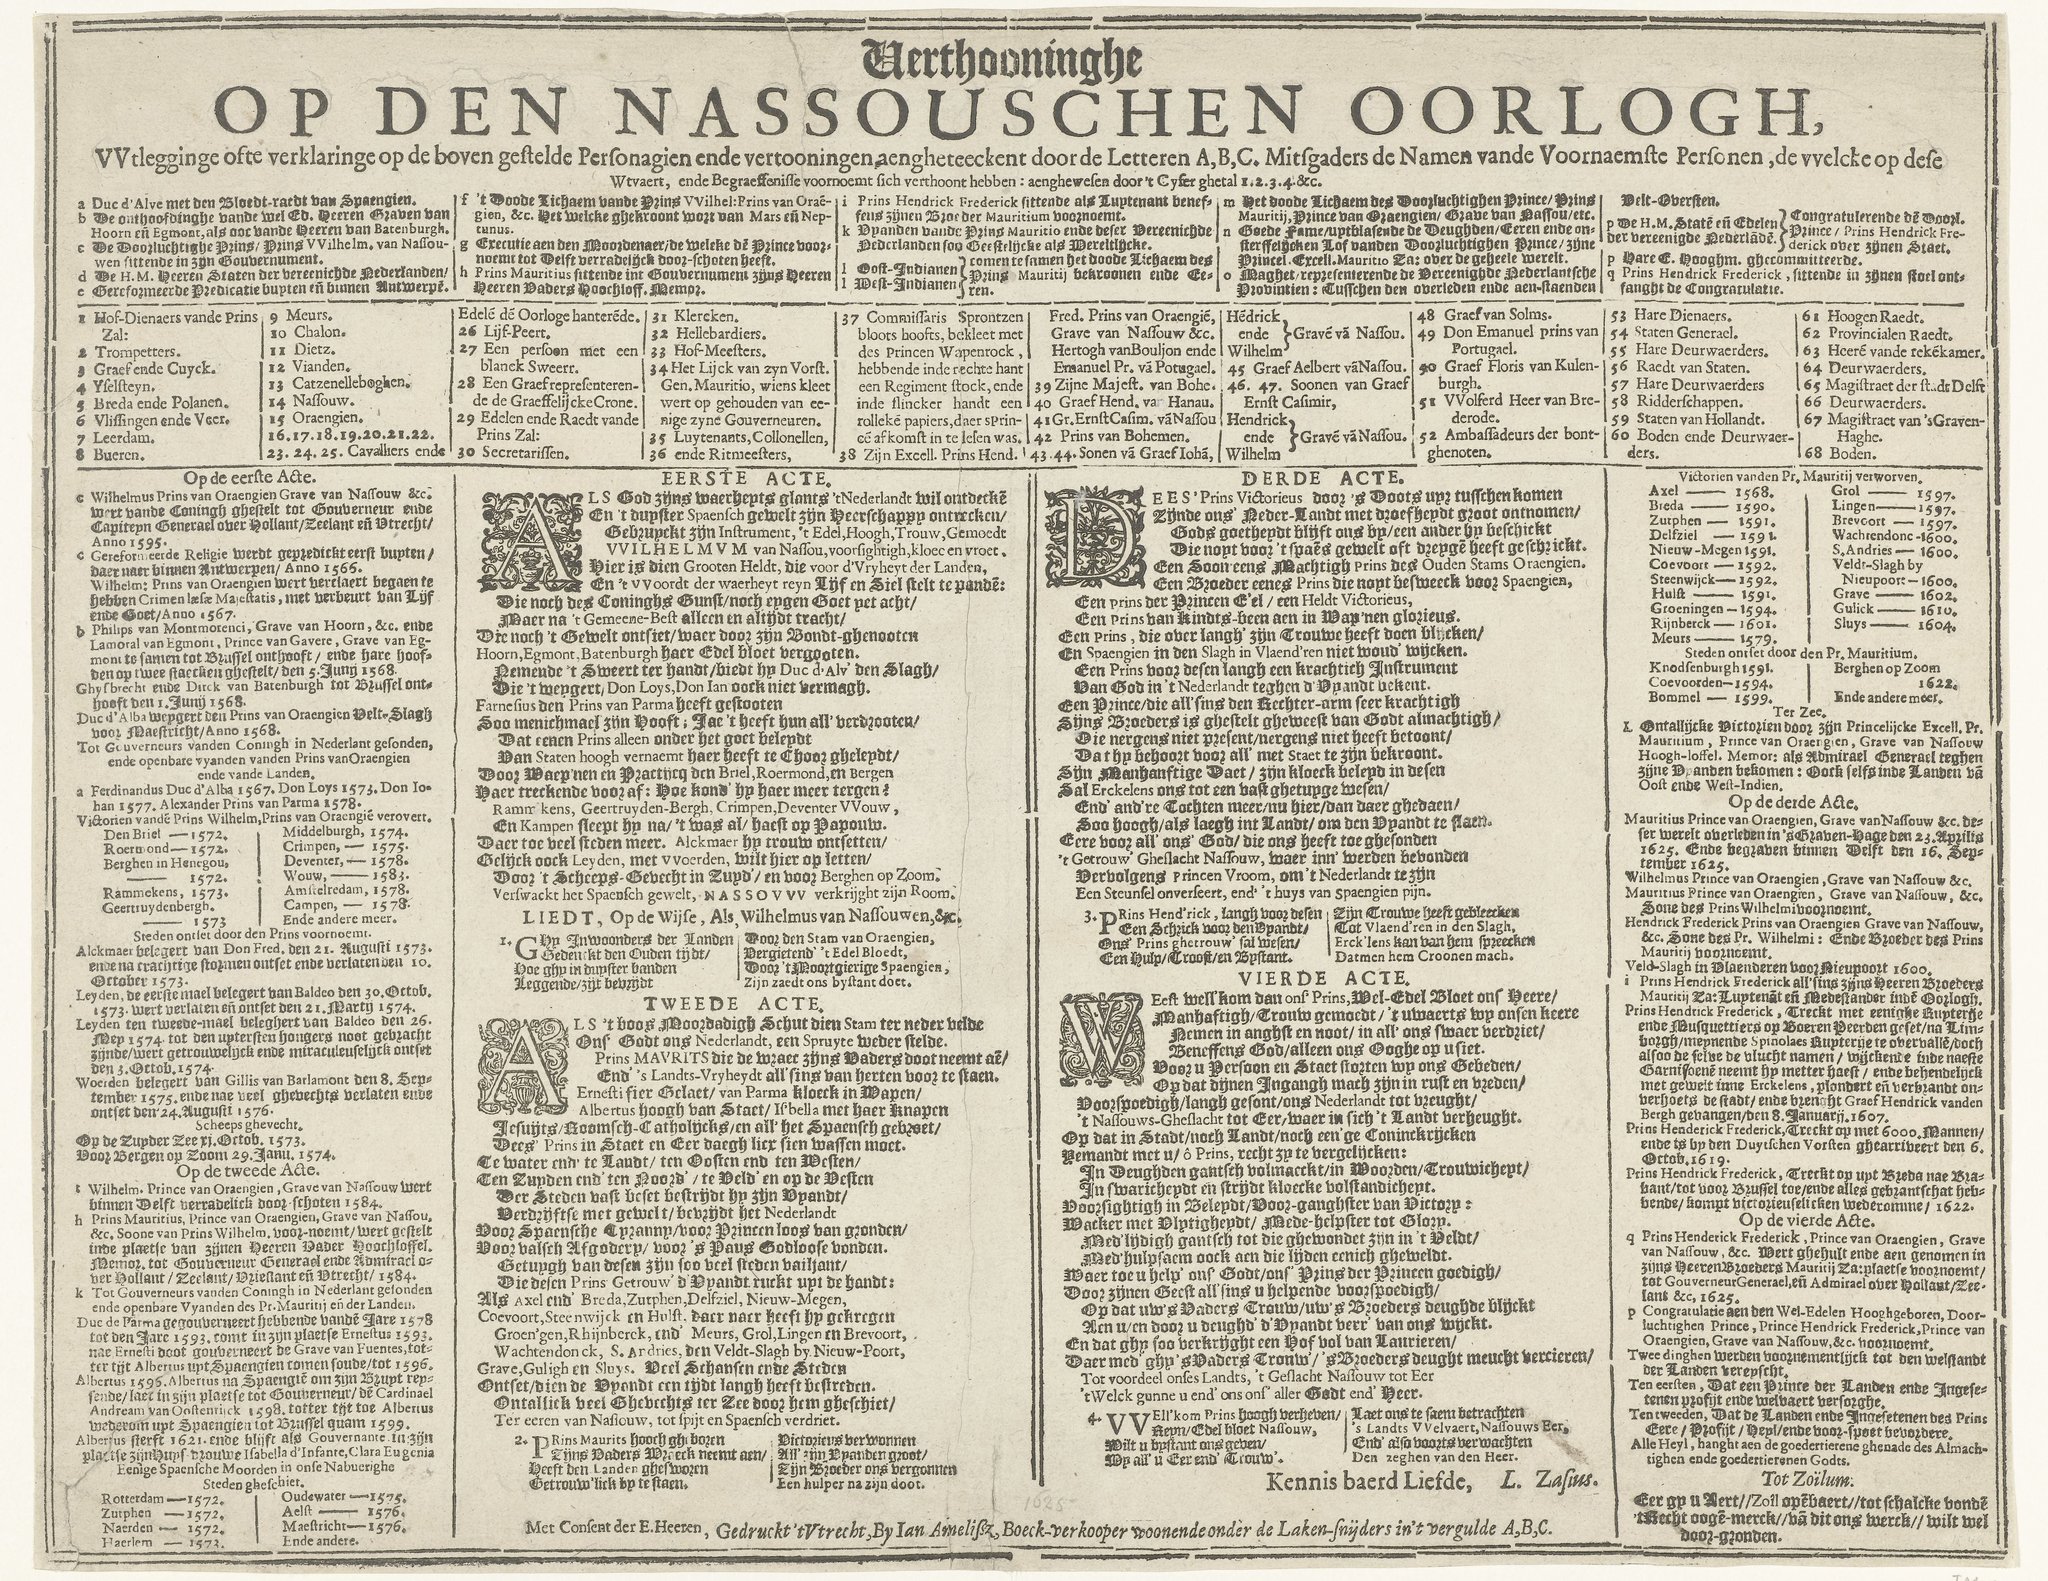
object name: propagandaprent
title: Tekstblad voor het Monument voor de Nassause Oorlog, 1625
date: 1625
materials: paper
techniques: letterpress printing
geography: utrecht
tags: delft, the hague, frederick henry (prince of orange), william i (prince of orange), maurice (prince of orange)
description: Tekstblad voor het Monument voor de Nassause Oorlog, 1625. Verklaring van de letters a-q op het monument, 1-68 op de begrafenisstoet en verzen en beschrijvingen van de vier actes.